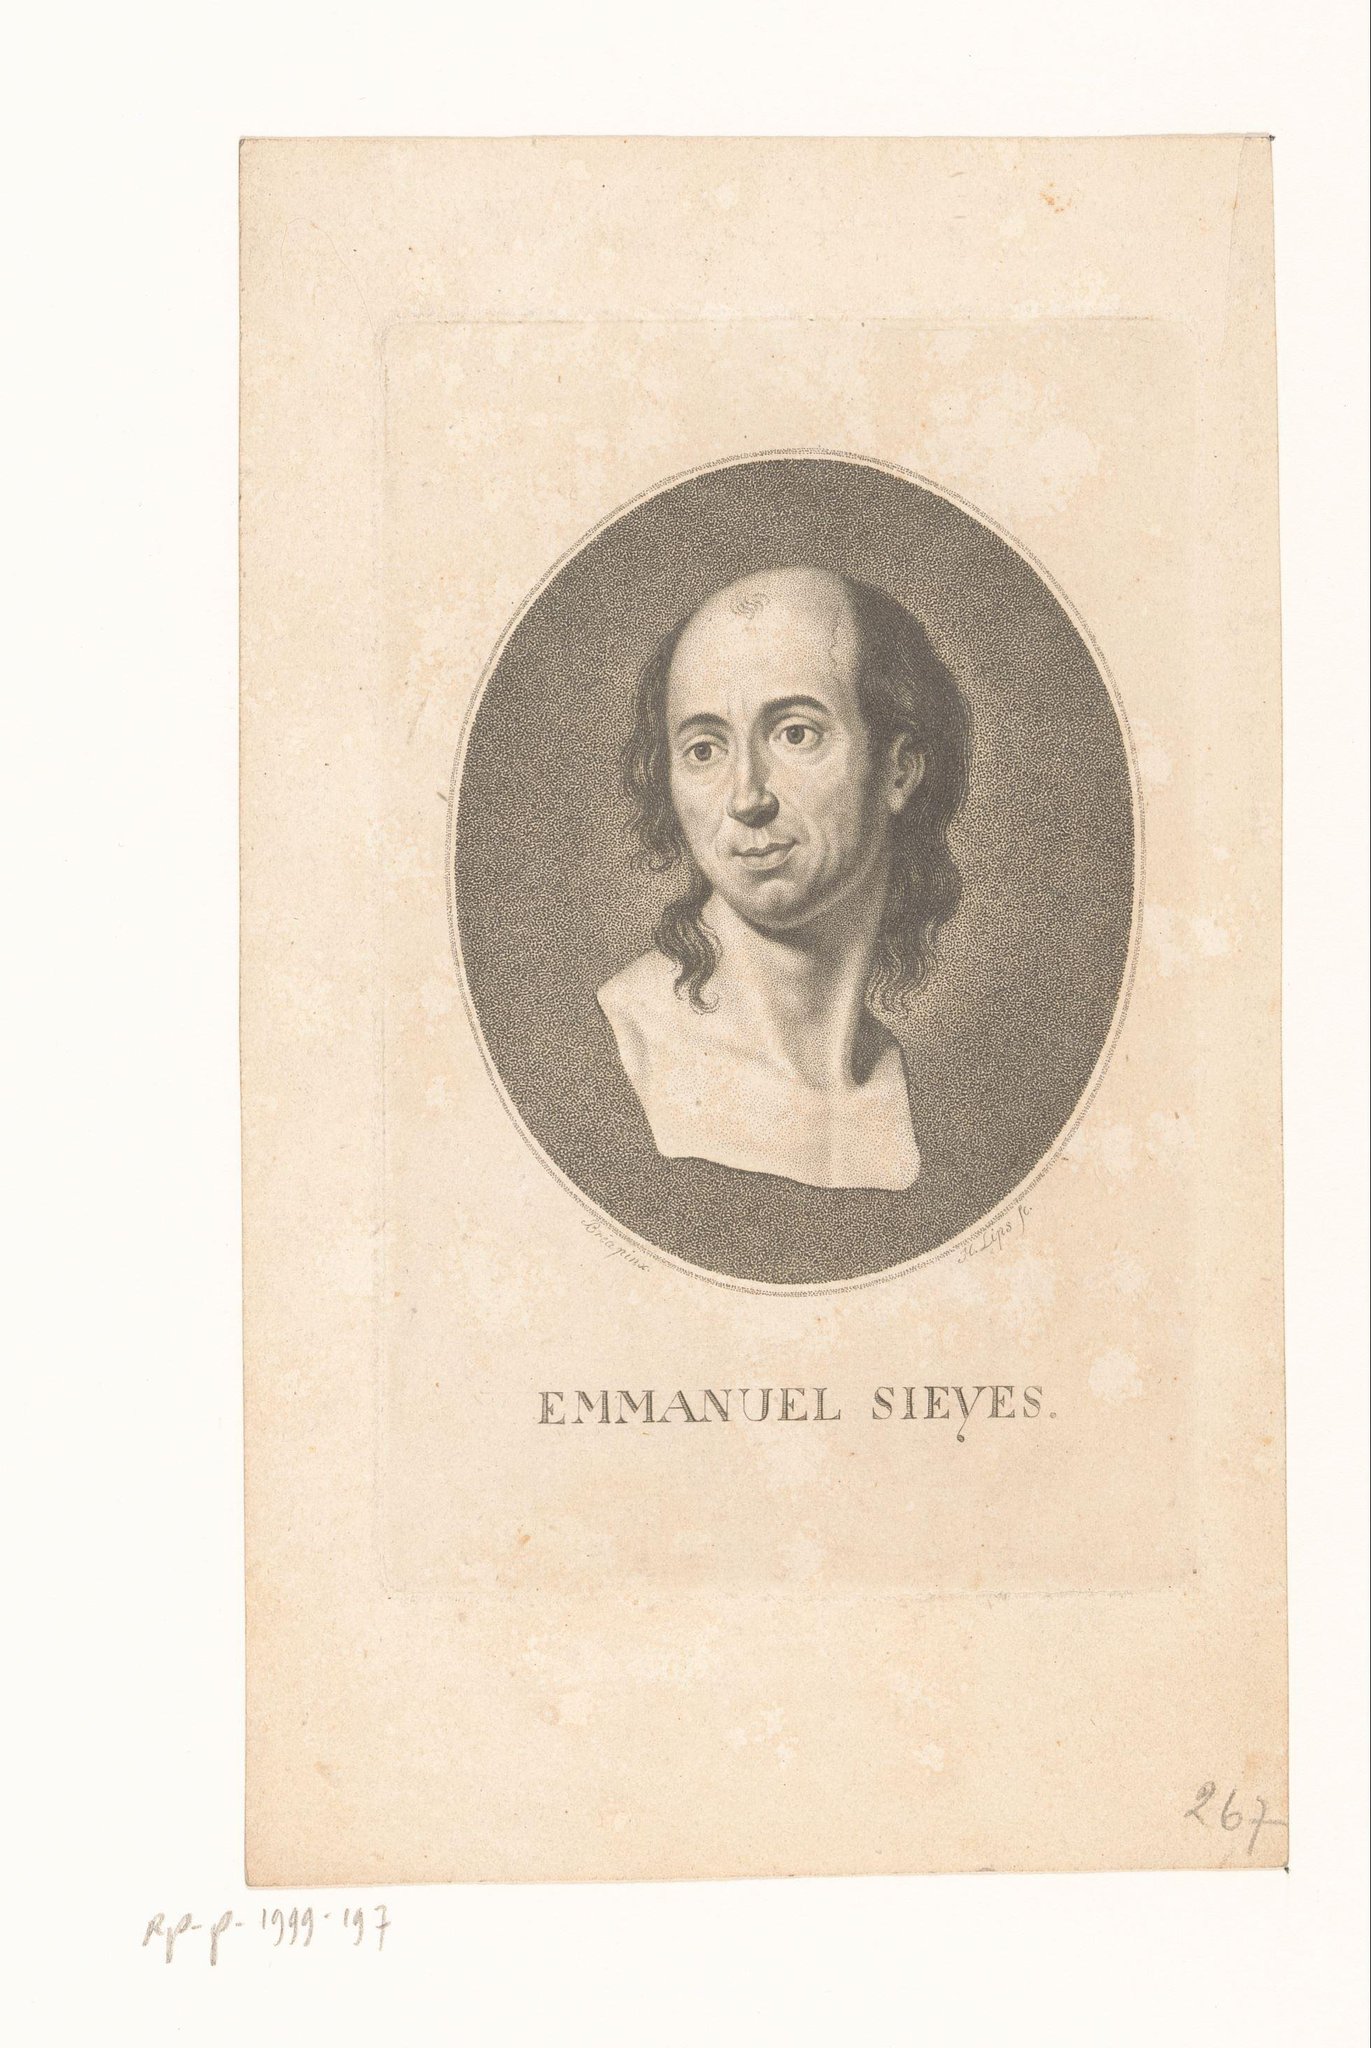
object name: print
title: Portret van Emmanuel Joseph Sieyès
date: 1768-1817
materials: paper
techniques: stippling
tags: politician, historical persons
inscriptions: collector's mark: Lugt 2228, collector's mark: Lugt 2760